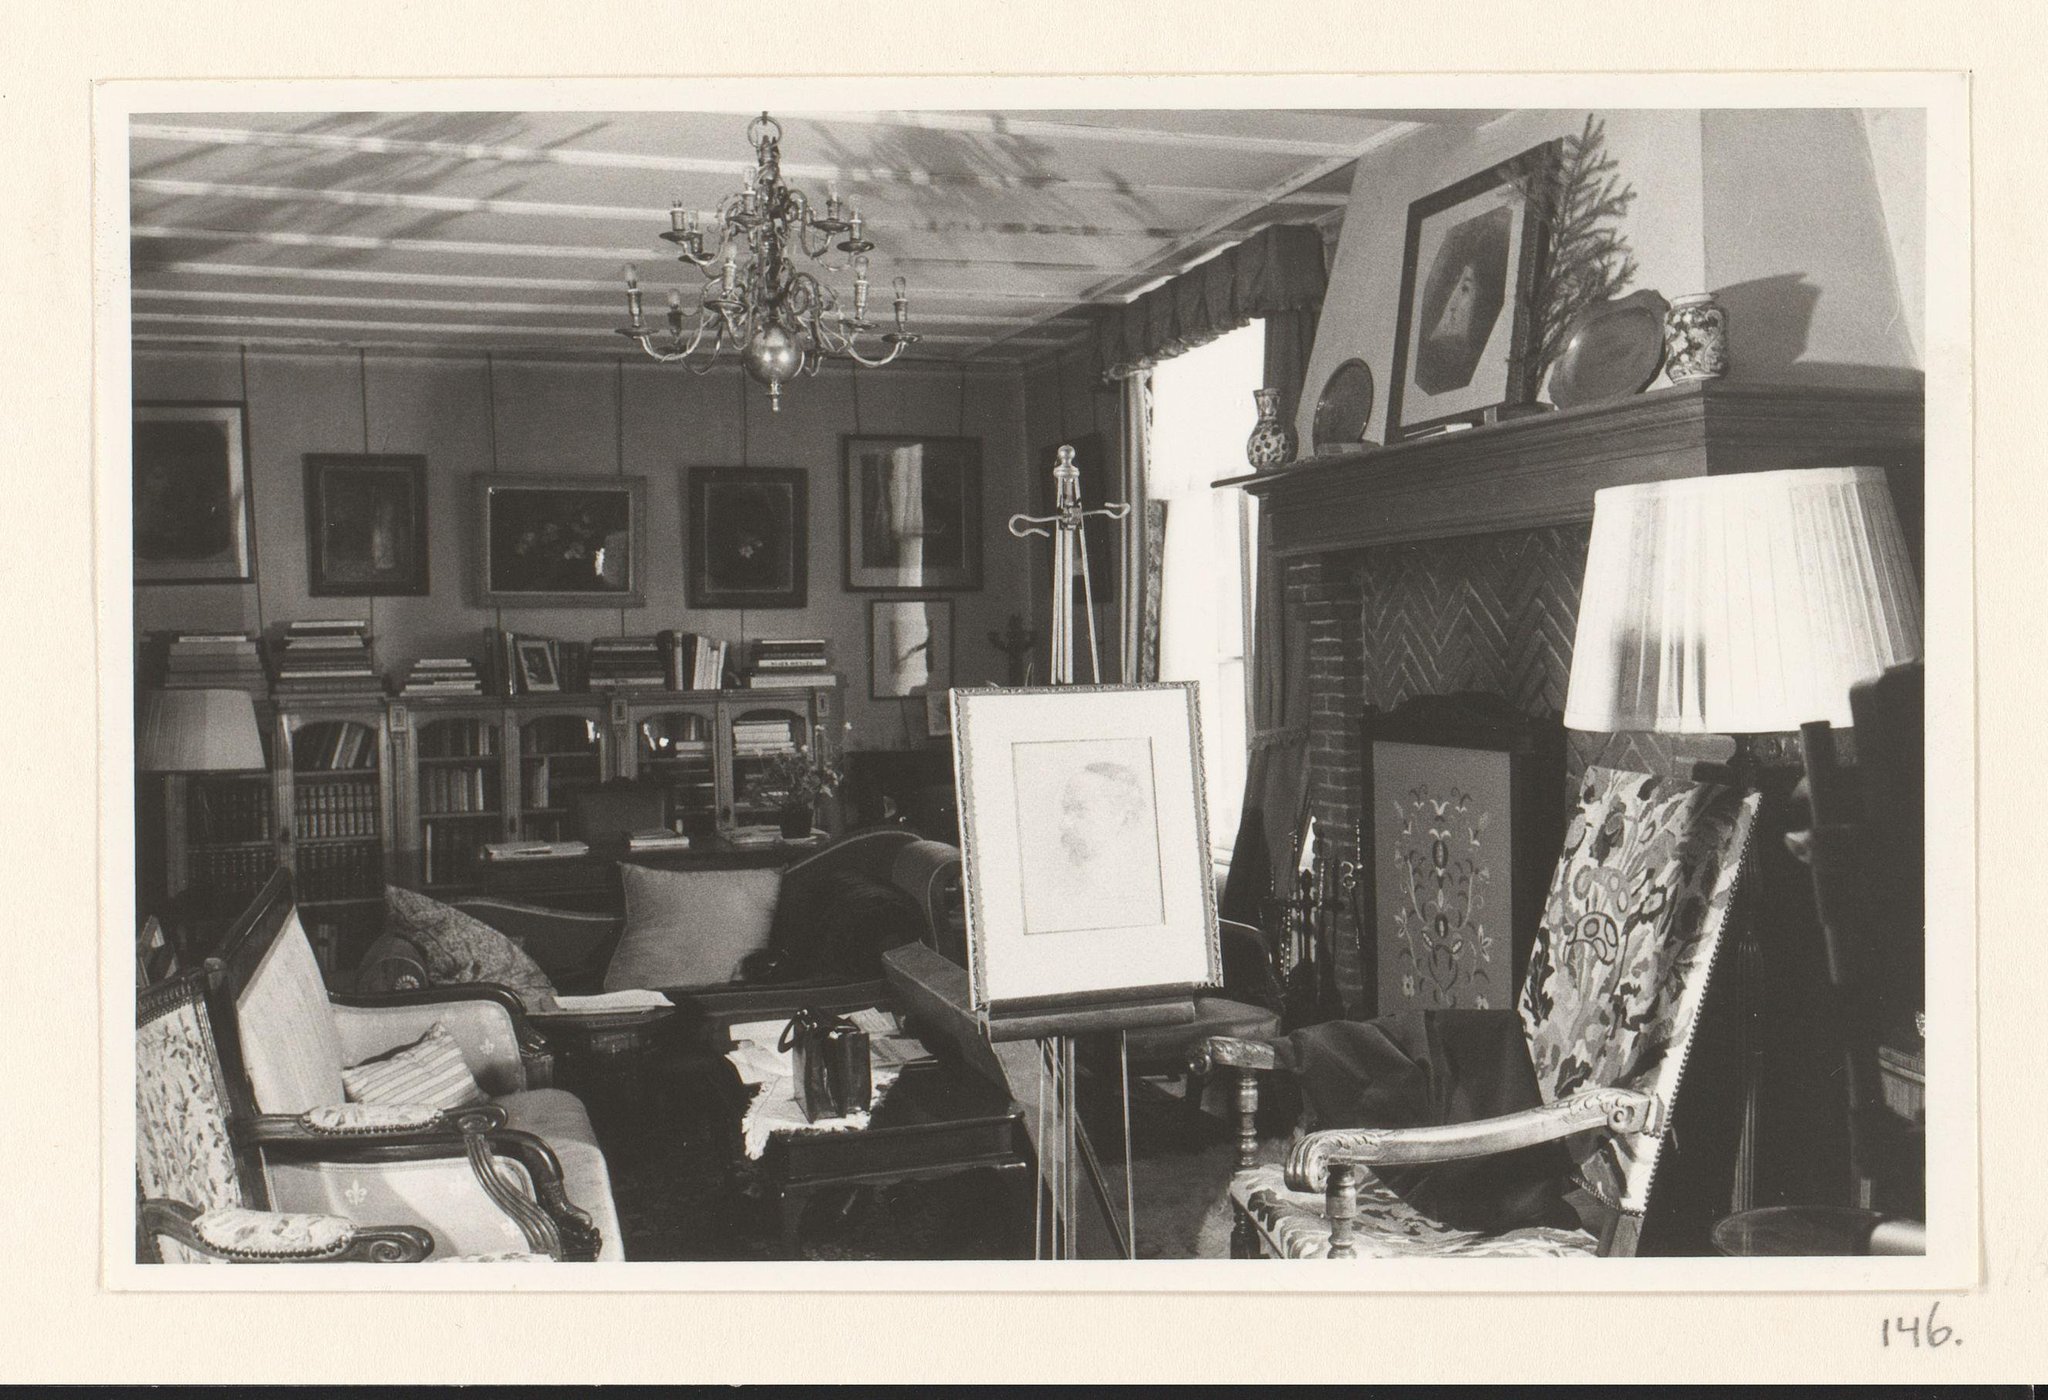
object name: photograph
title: Interieur van het huis Groot Have te Almen, met op de ezel een portret van Andries Bonger in rood krijt door Odilon Redon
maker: Anonymous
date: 1937-1975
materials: cardboard, paper, photographic support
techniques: gelatin silver print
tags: amsterdam, andries bonger, interior of the house, other dwelling types